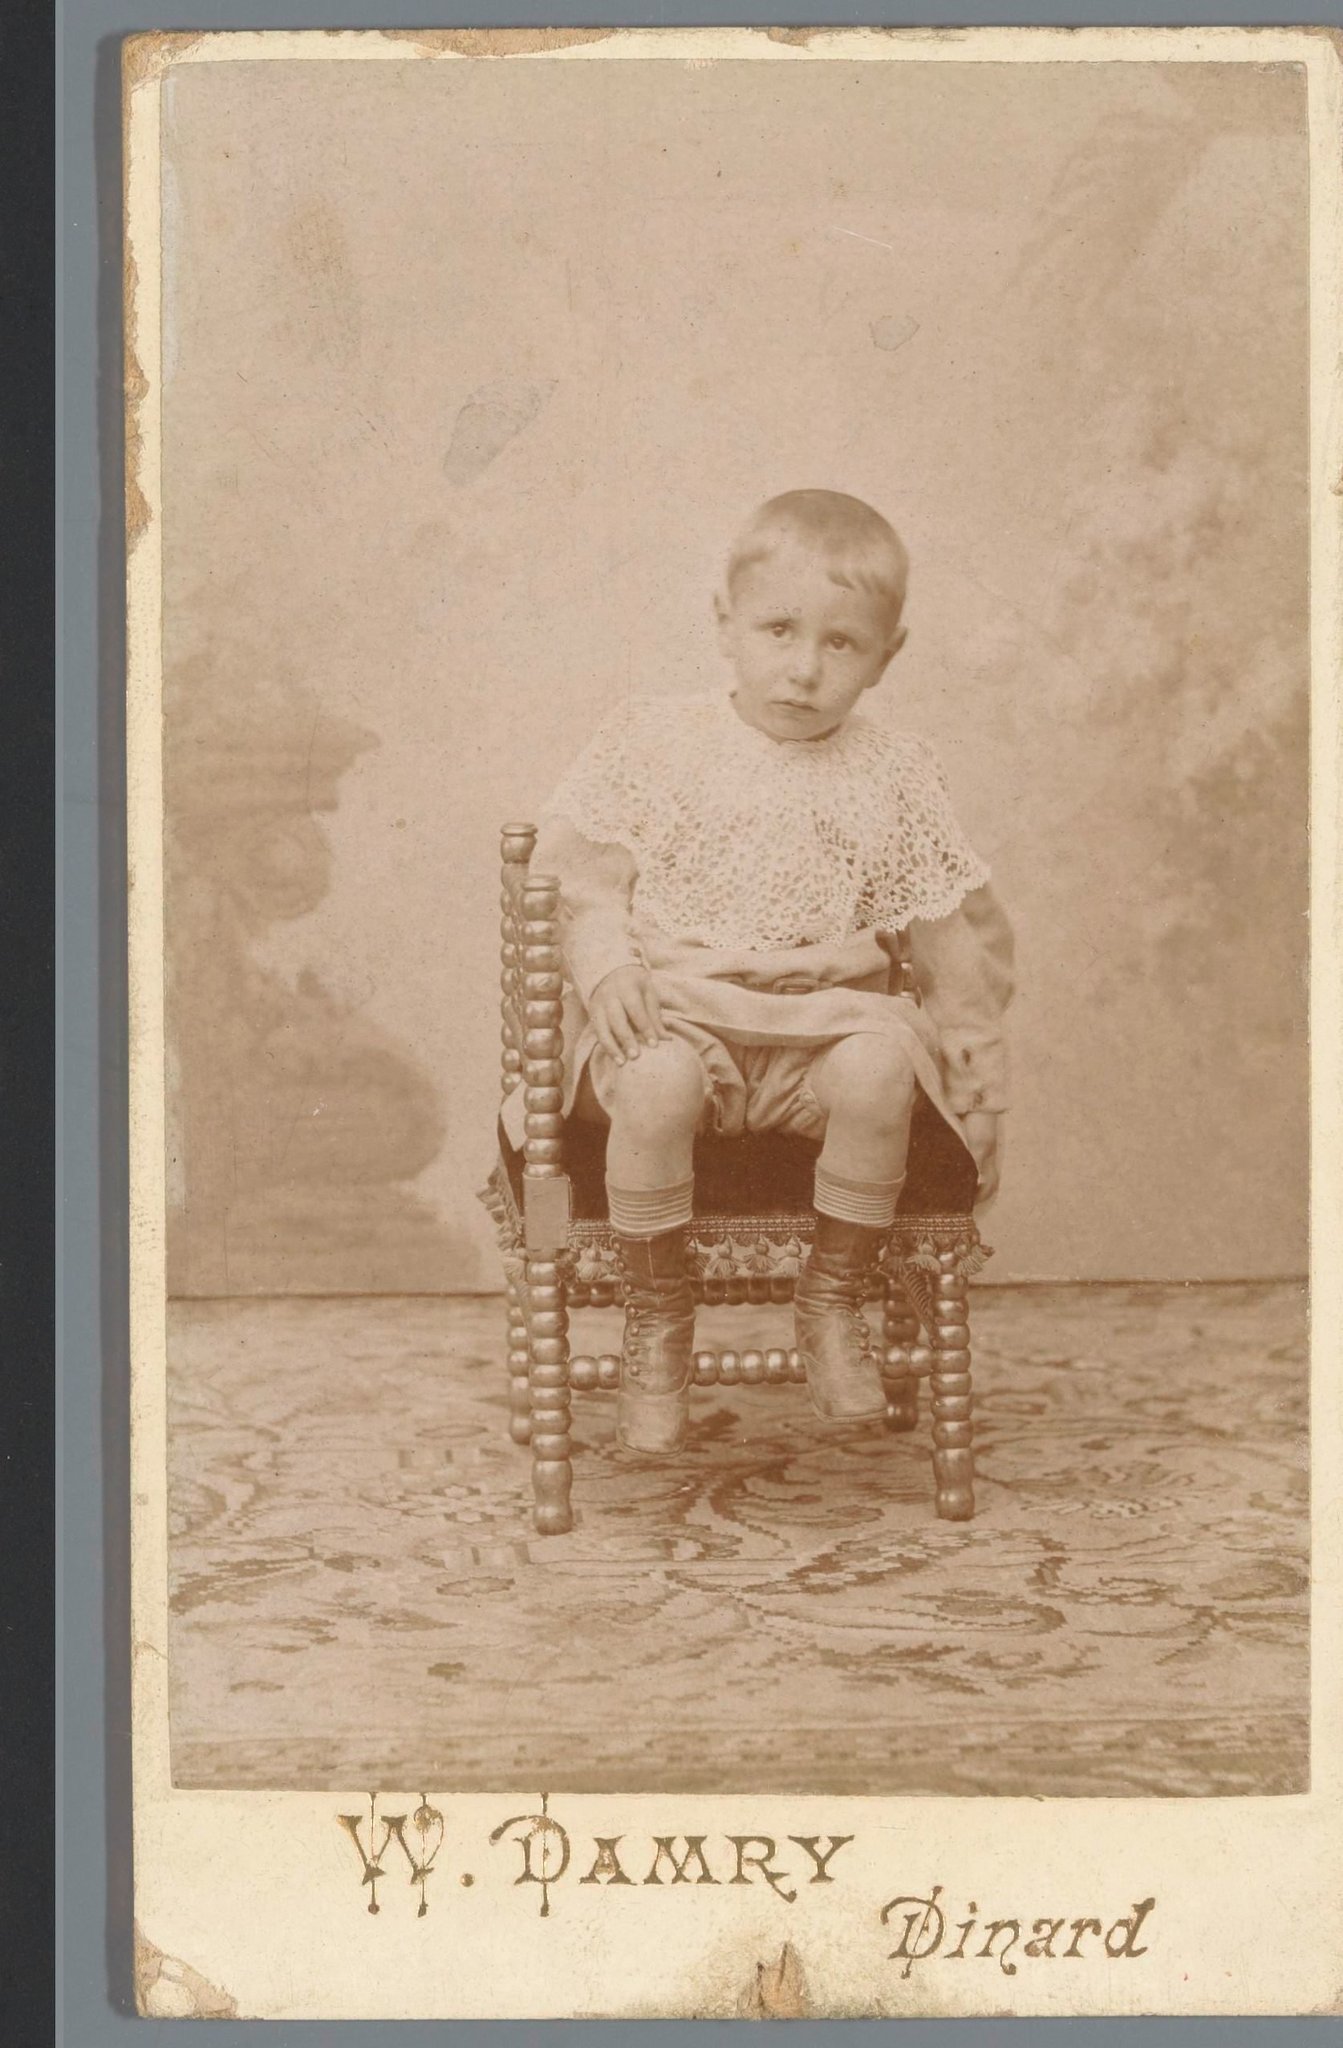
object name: carte de visite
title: Portret van een onbekende jongen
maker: walter damry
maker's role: fotograaf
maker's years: 1833-1890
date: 1892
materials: paper, cardboard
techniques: collodion silver print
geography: dinard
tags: boy (child between toddler and youth), anonymous historical person portrayed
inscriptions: inscription: ‘W. Damry/ Villa Claudine/ Dinard/ Spécialité d'Agrandissements Inaltérables/ Tochon-Lepage - Paris’, inscription: ‘W. Damry/ Dinard’